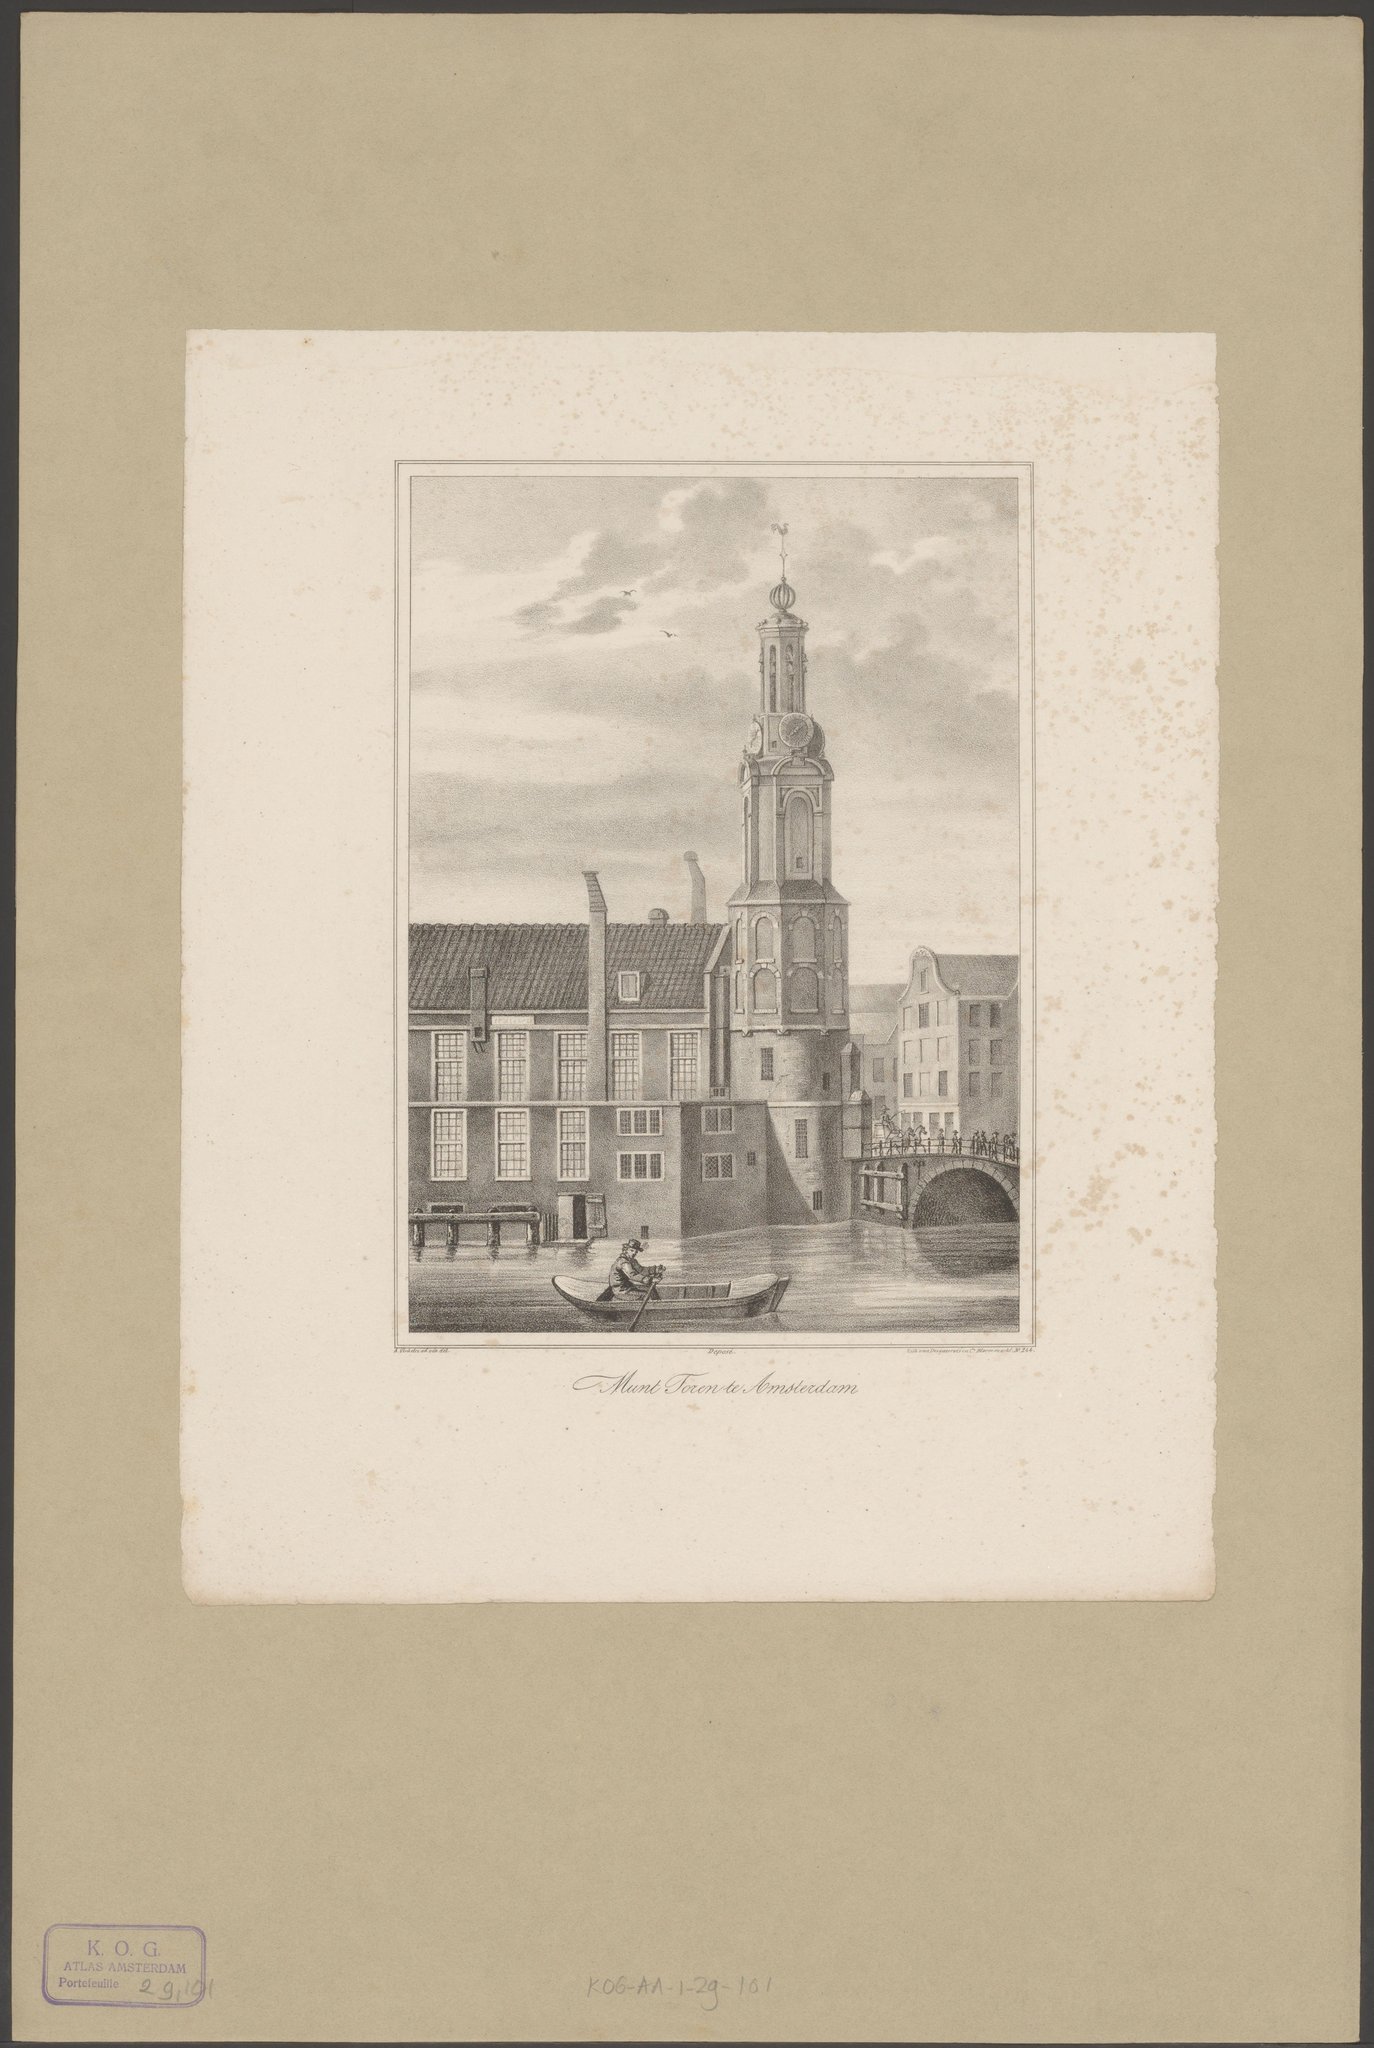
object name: print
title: Munt Toren te Amsterdam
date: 1828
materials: paper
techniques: lithograph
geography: netherlands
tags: bridge in city across river, canal, etc. (+ city(-scape) with figures, staffage), tower, clock tower ~ monumental adornment, rowing-boat, canoe, etc.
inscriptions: collector's mark: Lugt 1641b, : ‘Deposé.’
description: Prent maakt onderdeel uit van de serie: Gezichten van de Zes Voornaamste Torens der Stad Amsterdam. 2de Cahier. Amsterdam: Desguerrois & Co., [1828].